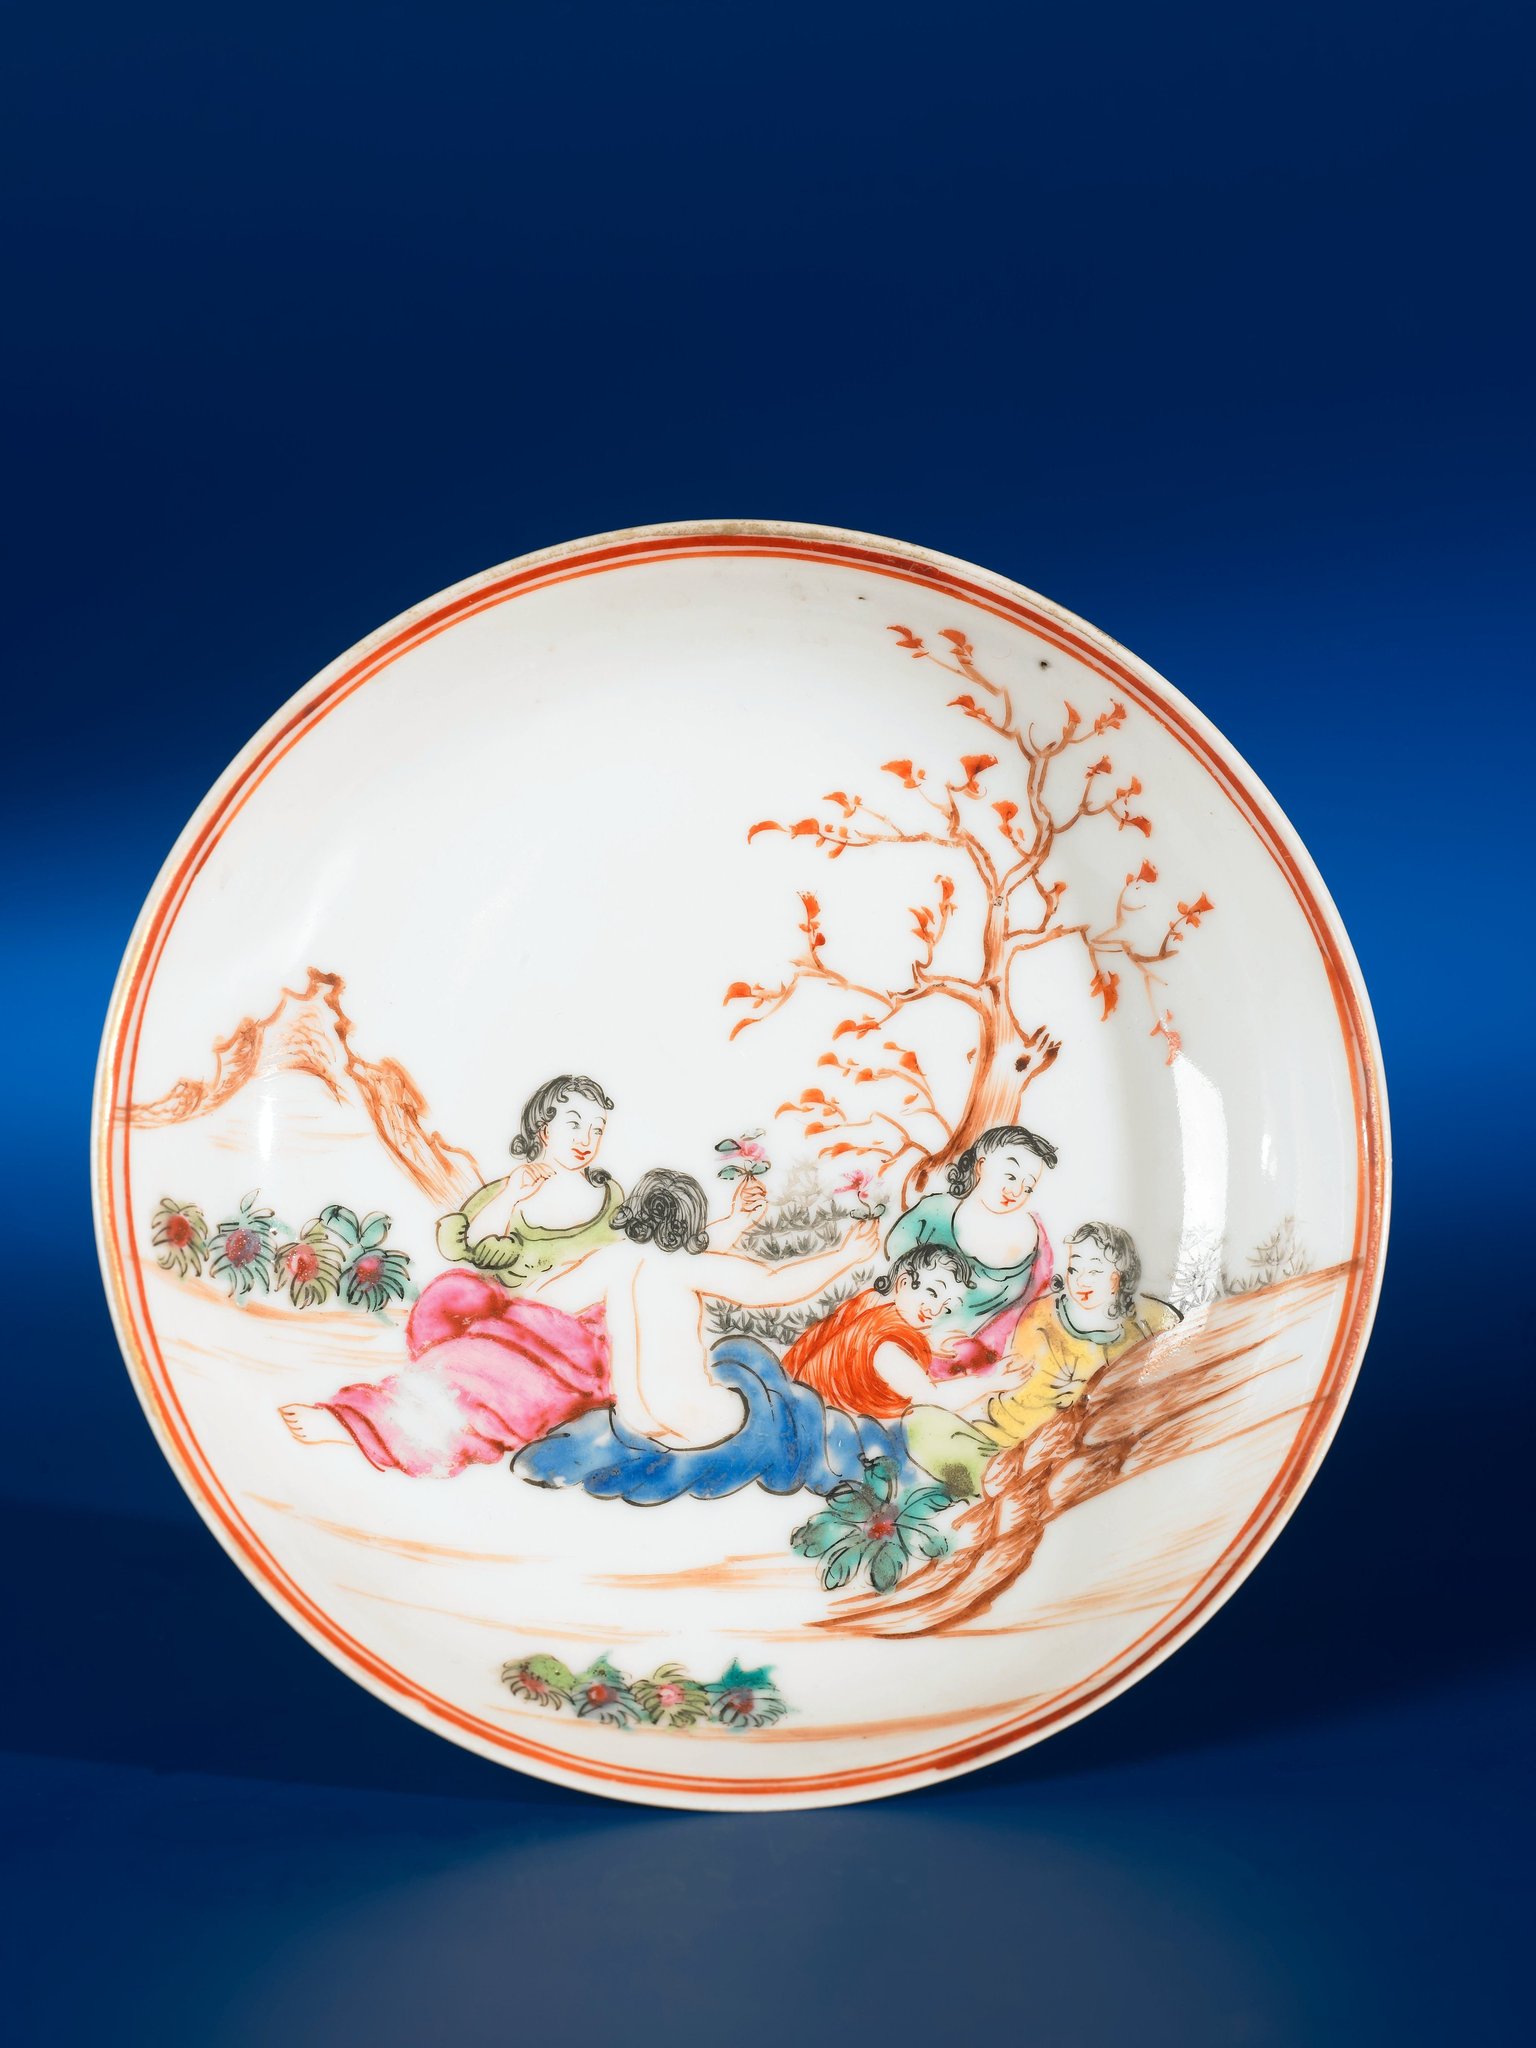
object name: dish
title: Saucer with a group of figures in a landscape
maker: Anonymous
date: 1750-1774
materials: glaze, paint, porcelain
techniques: firing, turning, vitrification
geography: china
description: Schaal op een voetring, gedecoreerd in emailkleuren. Afgebeeld zijn vijf Europese figuren in klassieke gewaden in een landschap, bergen op de achtergrond. De betekenis van de voorstelling is onduidelijk, ook al heeft zeer waarschijnlijk een Europese prent als voorbeeld gediend. Het zou een mythologische voorstelling kunnen zijn.